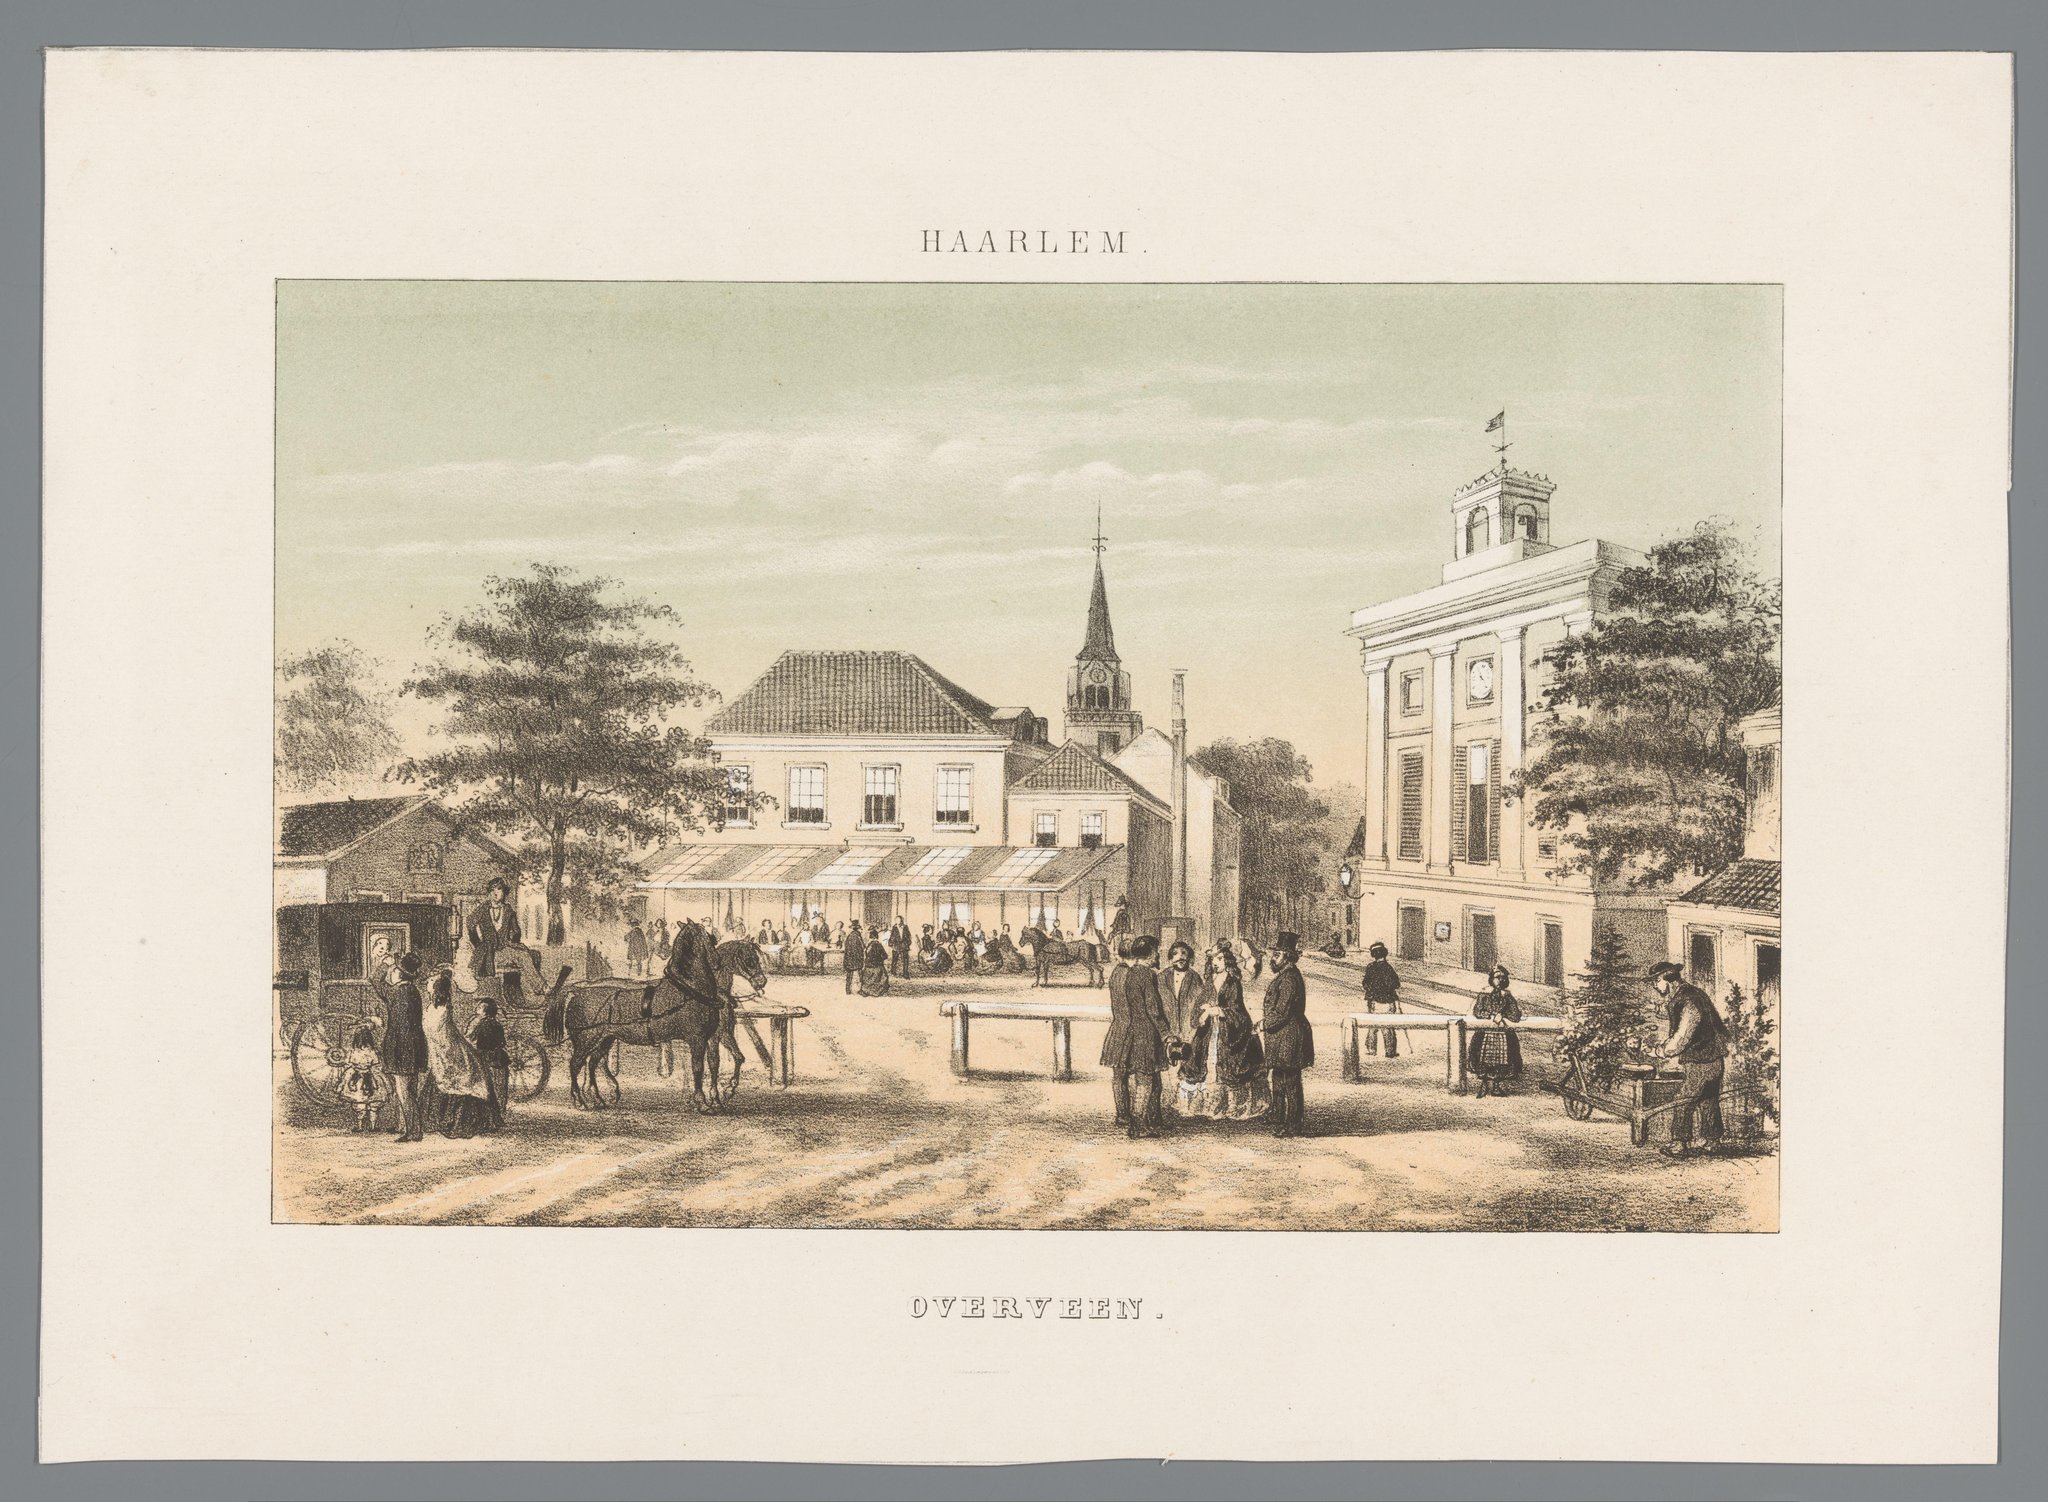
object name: print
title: Haarlem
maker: Anonymous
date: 1850-1900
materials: paper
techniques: iris print, lithograph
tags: church (exterior), village square, place (+ city(-scape) with figures, staffage)